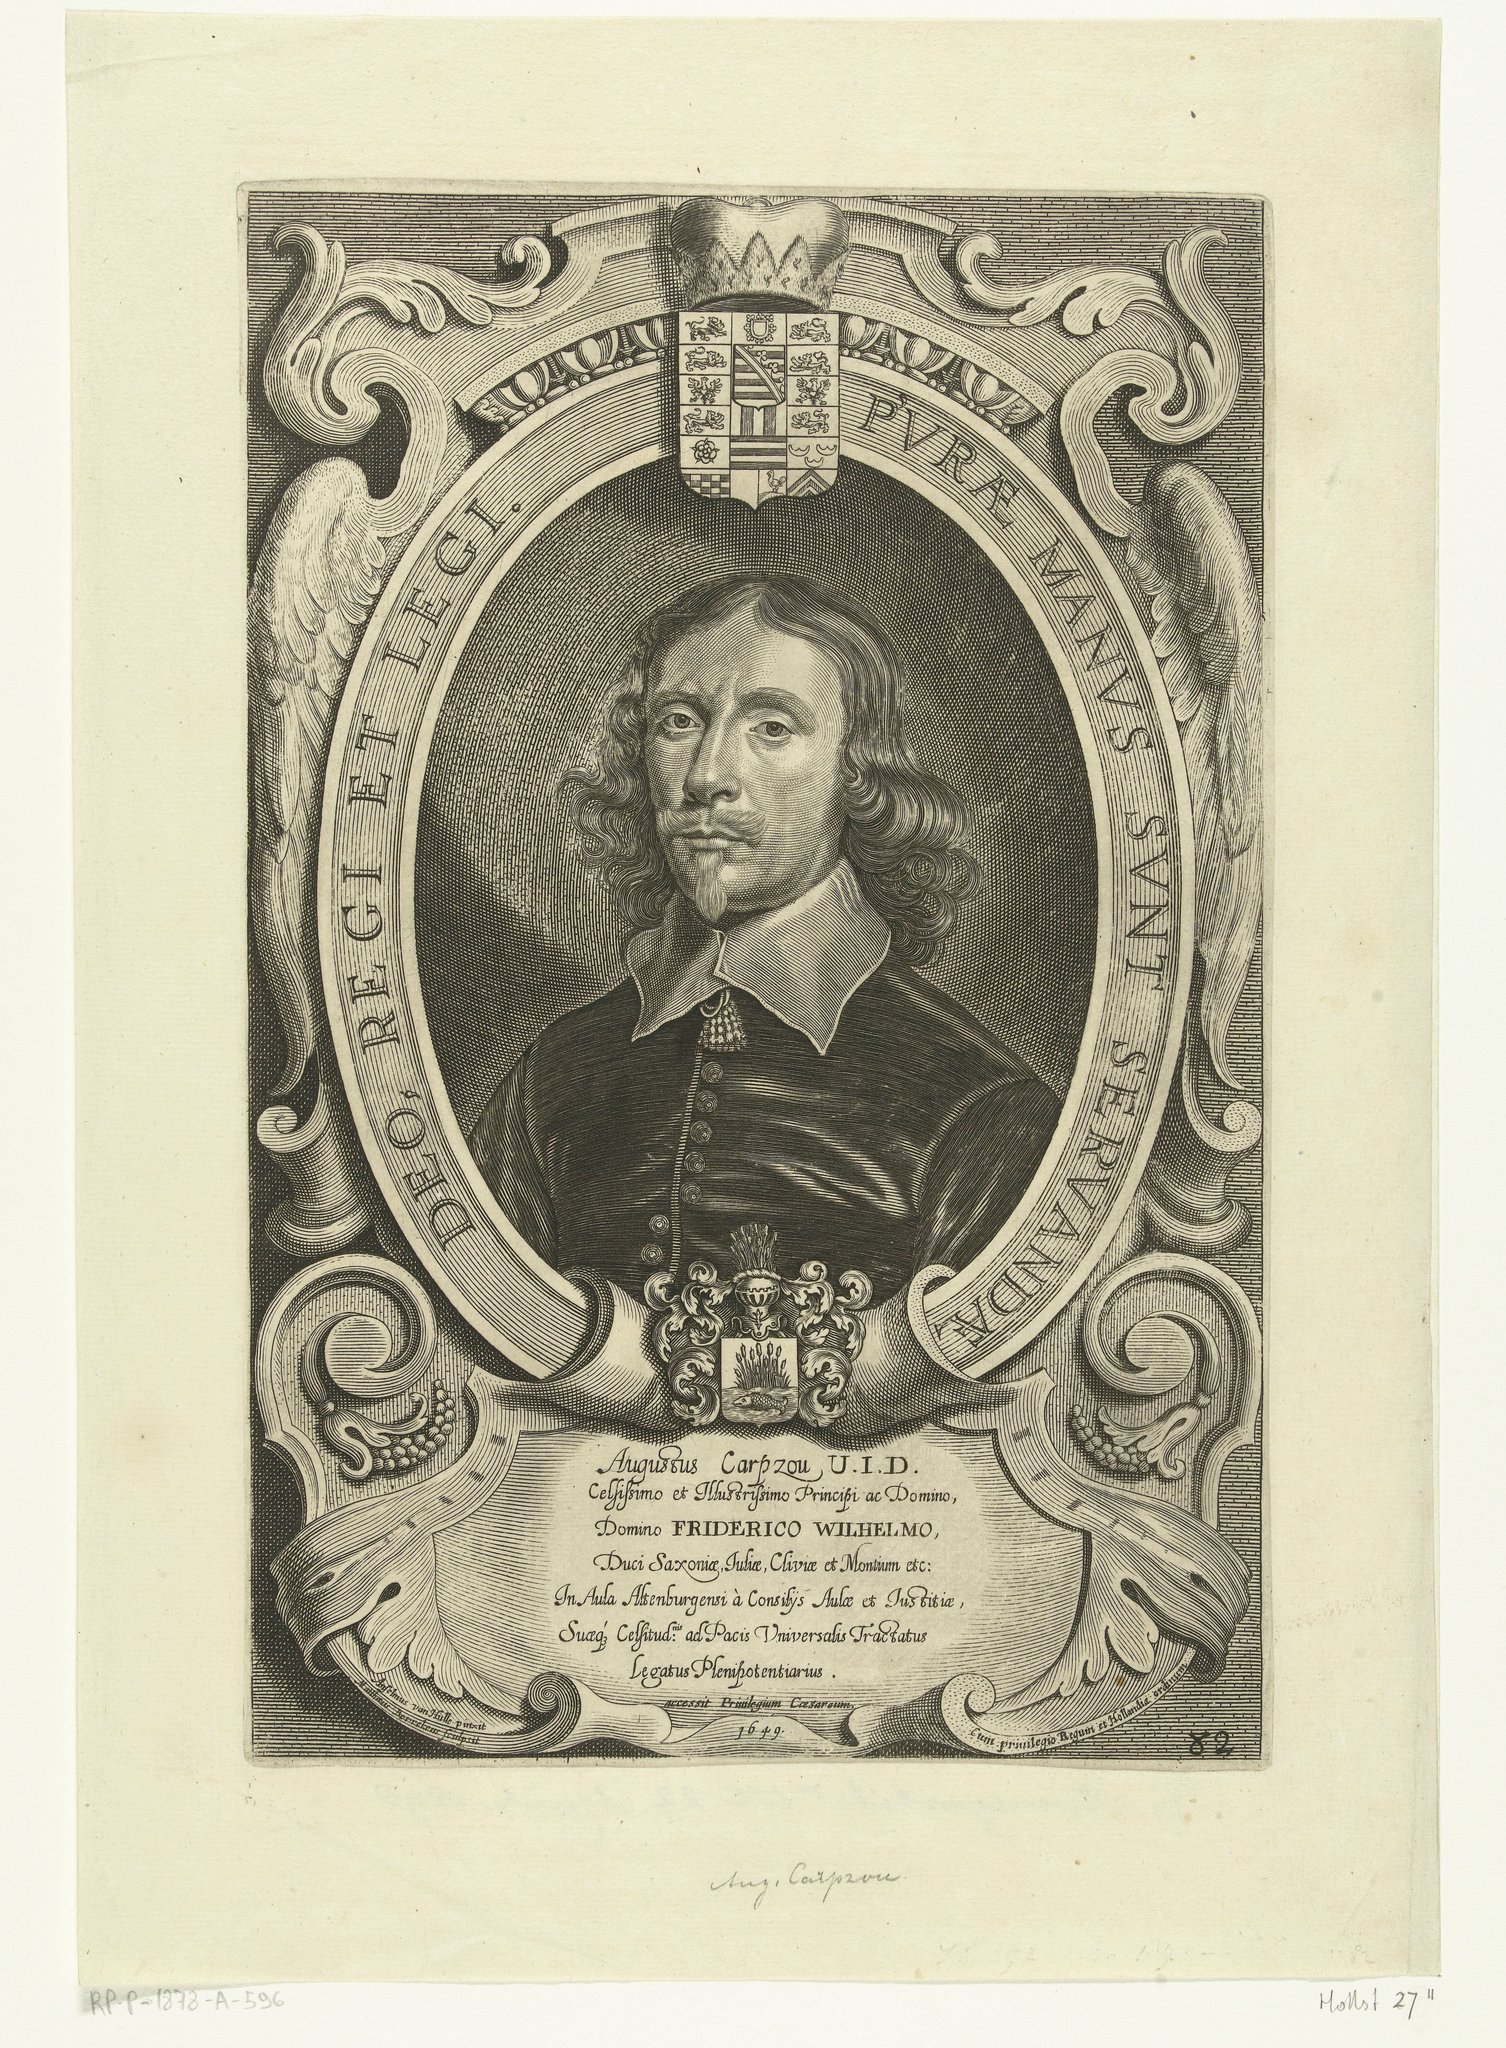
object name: print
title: Portret van Augustus Carpzow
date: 1649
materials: paper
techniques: engraving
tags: rechtsgeleerde, august carpzow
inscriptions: collector's mark: Lugt 2228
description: August Carpzow, onderhandelaar bij de Vrede van Munster. Portret in ovale lijst met buste naar links. De prent bevat een Latijns onderschrift in cartouche, een randschrift en ornament met wapen bovenaan.